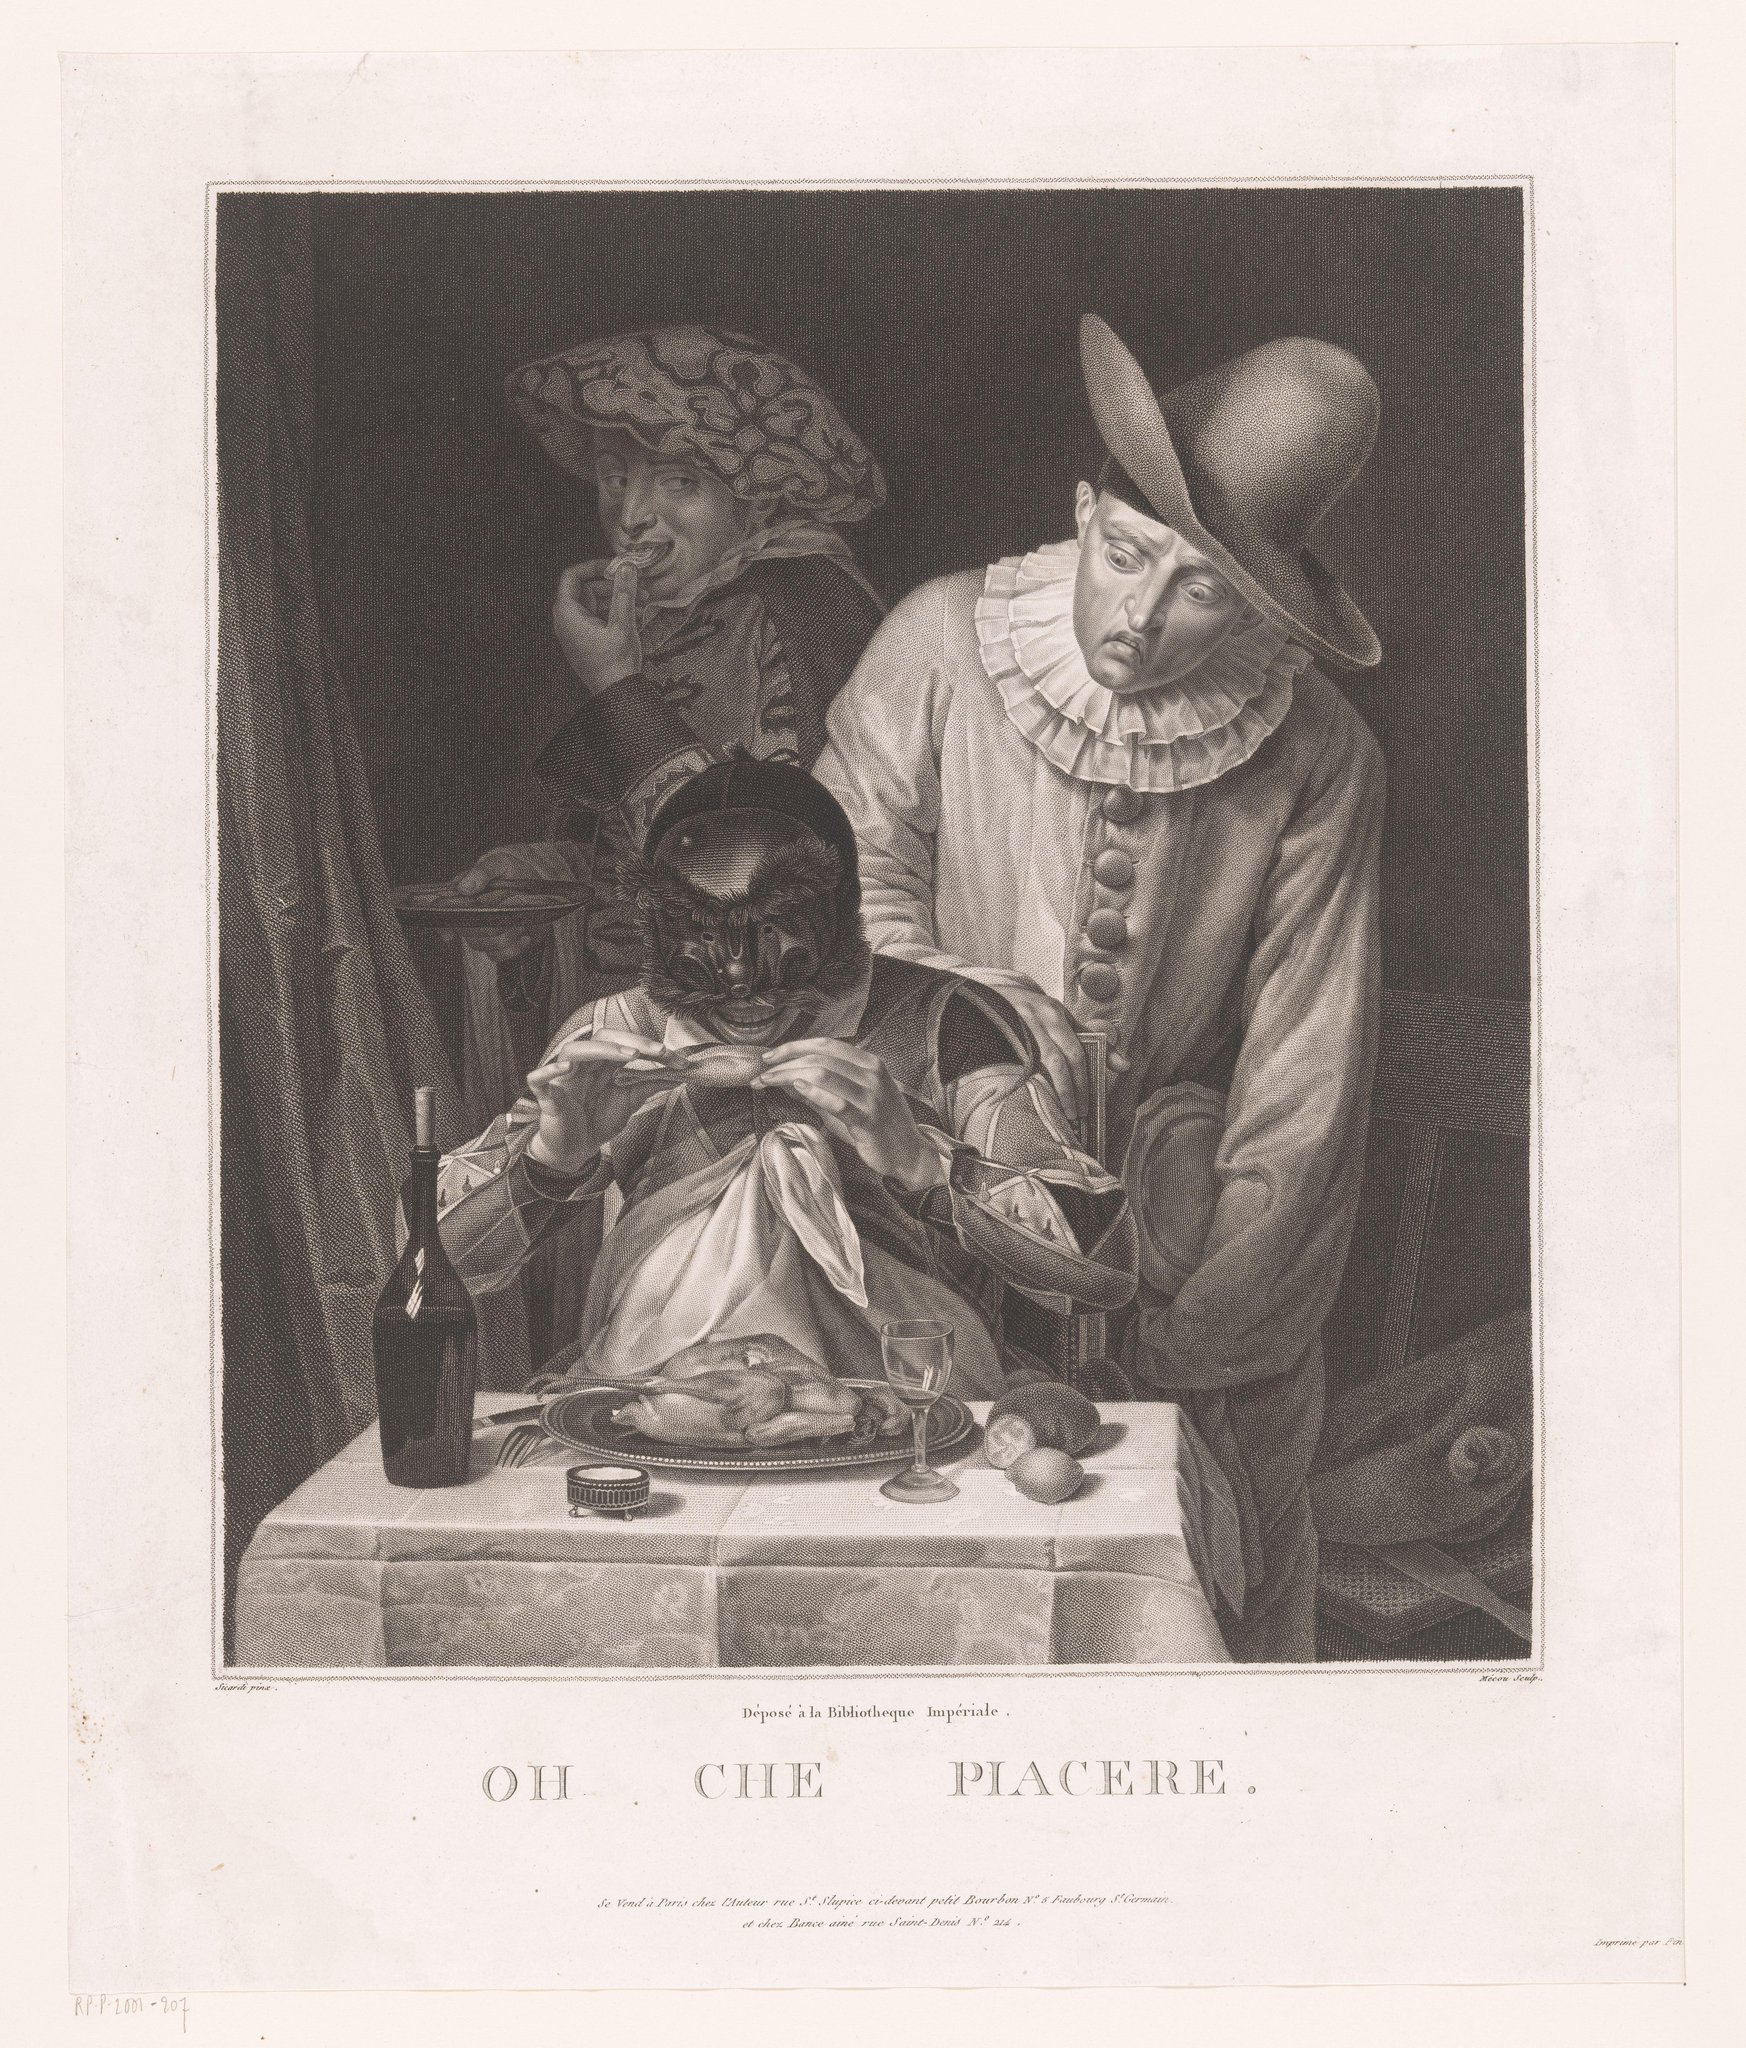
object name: print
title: Gemaskerde man met Pierrot en man met hoed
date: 1781-1837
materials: paper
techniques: engraving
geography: france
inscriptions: collector's mark: Lugt 2760, : ‘Déposé à la Bibliotheque Impériale.’, collector's mark: Lugt 2228